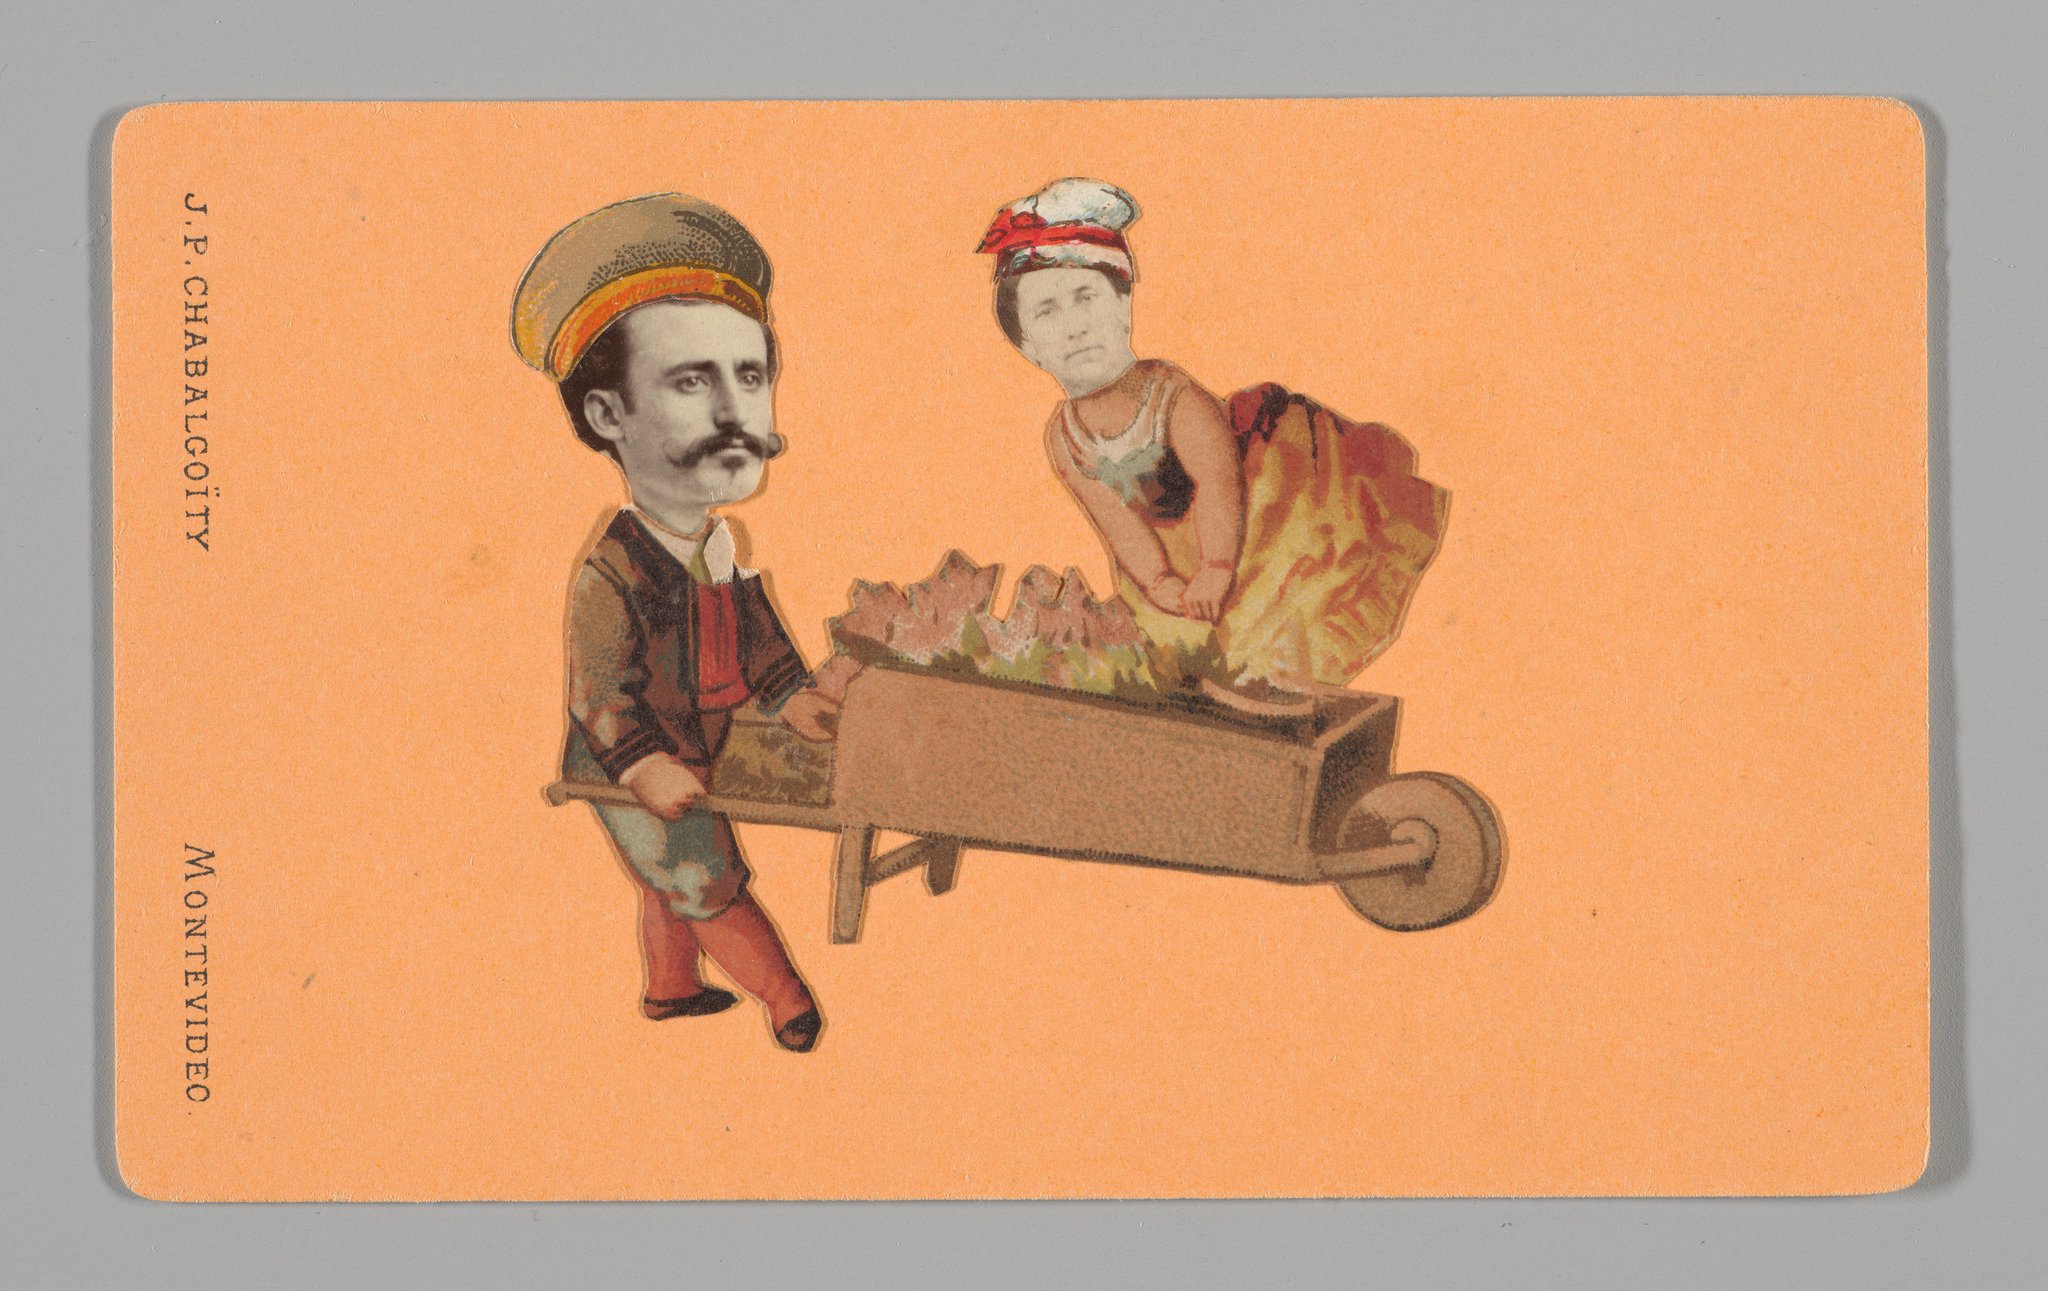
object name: carte de visite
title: [Photo Collage: Man Pushing Woman in Wheelbarrow]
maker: juan pedro chabalgoity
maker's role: artist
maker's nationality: uruguayan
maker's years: 1848-1909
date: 1875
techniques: albumen silver print, lithograph